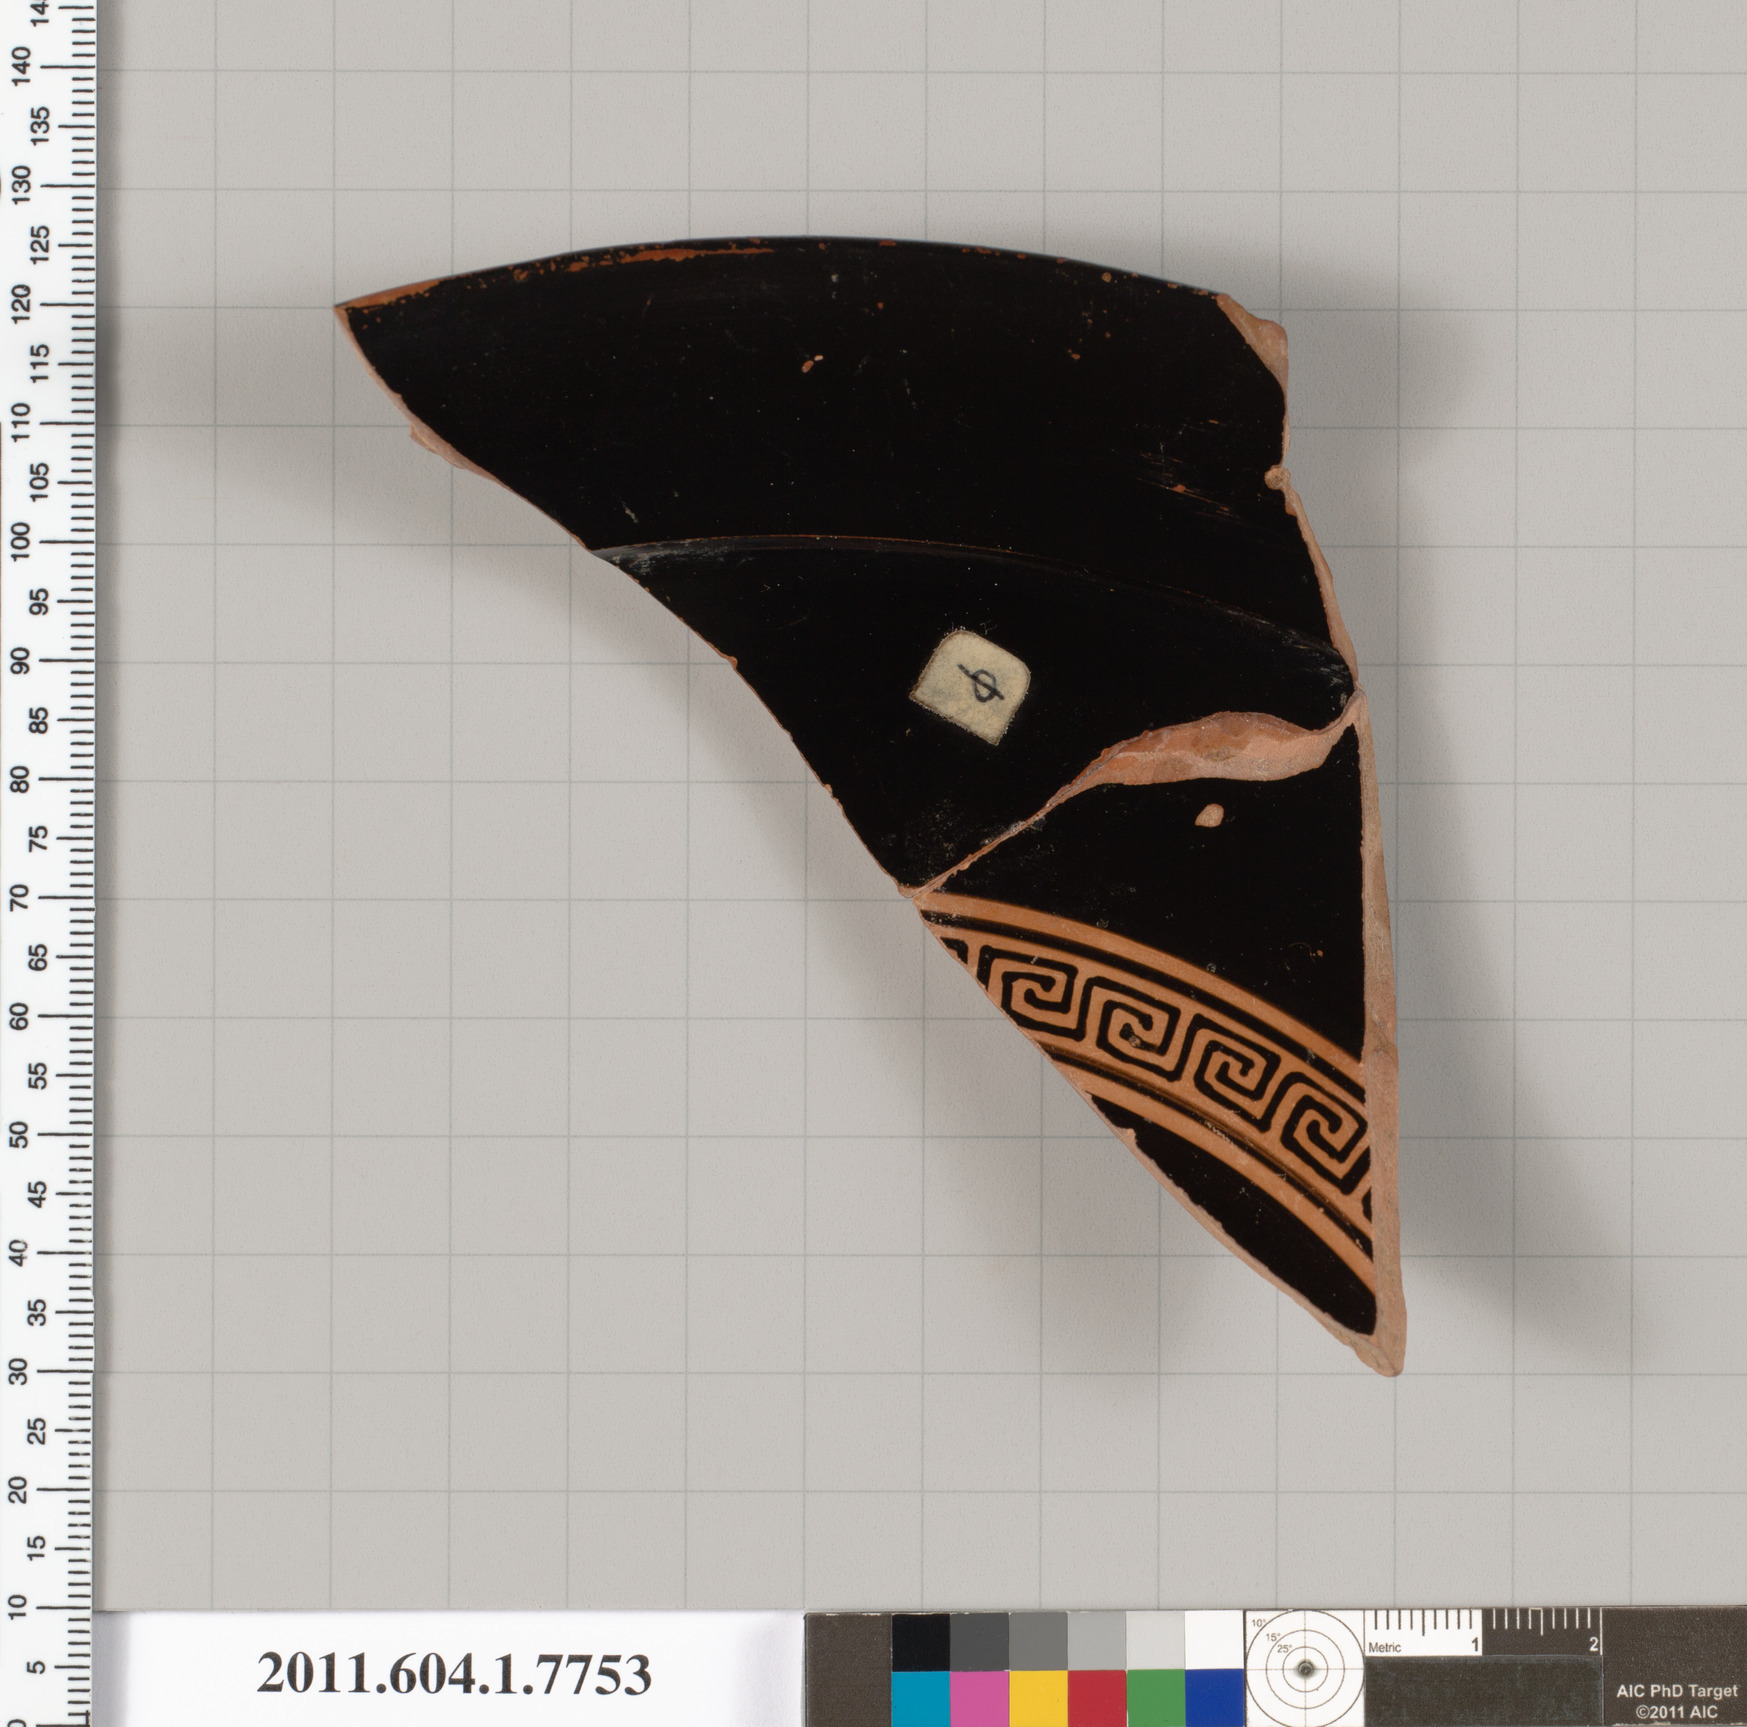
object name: kylix fragment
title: Terracotta rim fragment of a kylix (drinking cup)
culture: greek, attic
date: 470-450 BCE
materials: terracotta